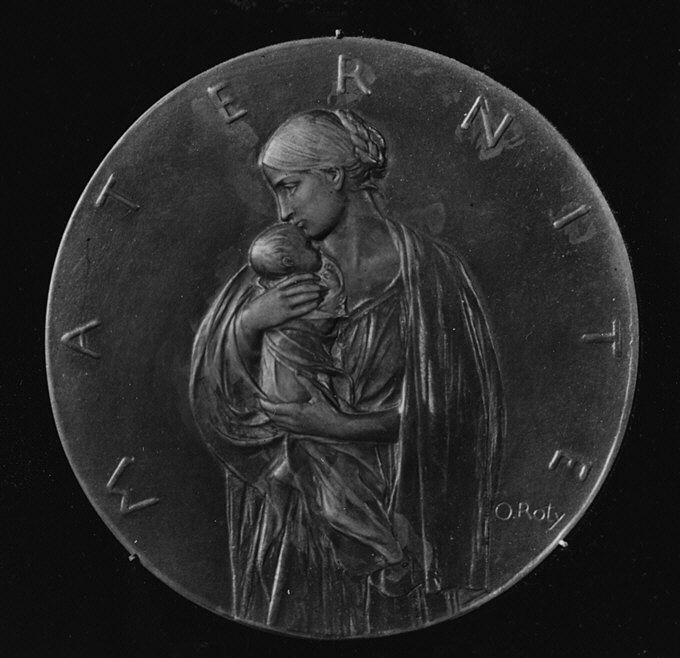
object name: jeton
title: Memorial of Baptism of the Artist's Son, Jean Georges Emile Roty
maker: louis-oscar roty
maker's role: artist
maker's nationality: french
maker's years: 1846-1911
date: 1893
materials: bronze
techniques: silvered, struck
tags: infants,women